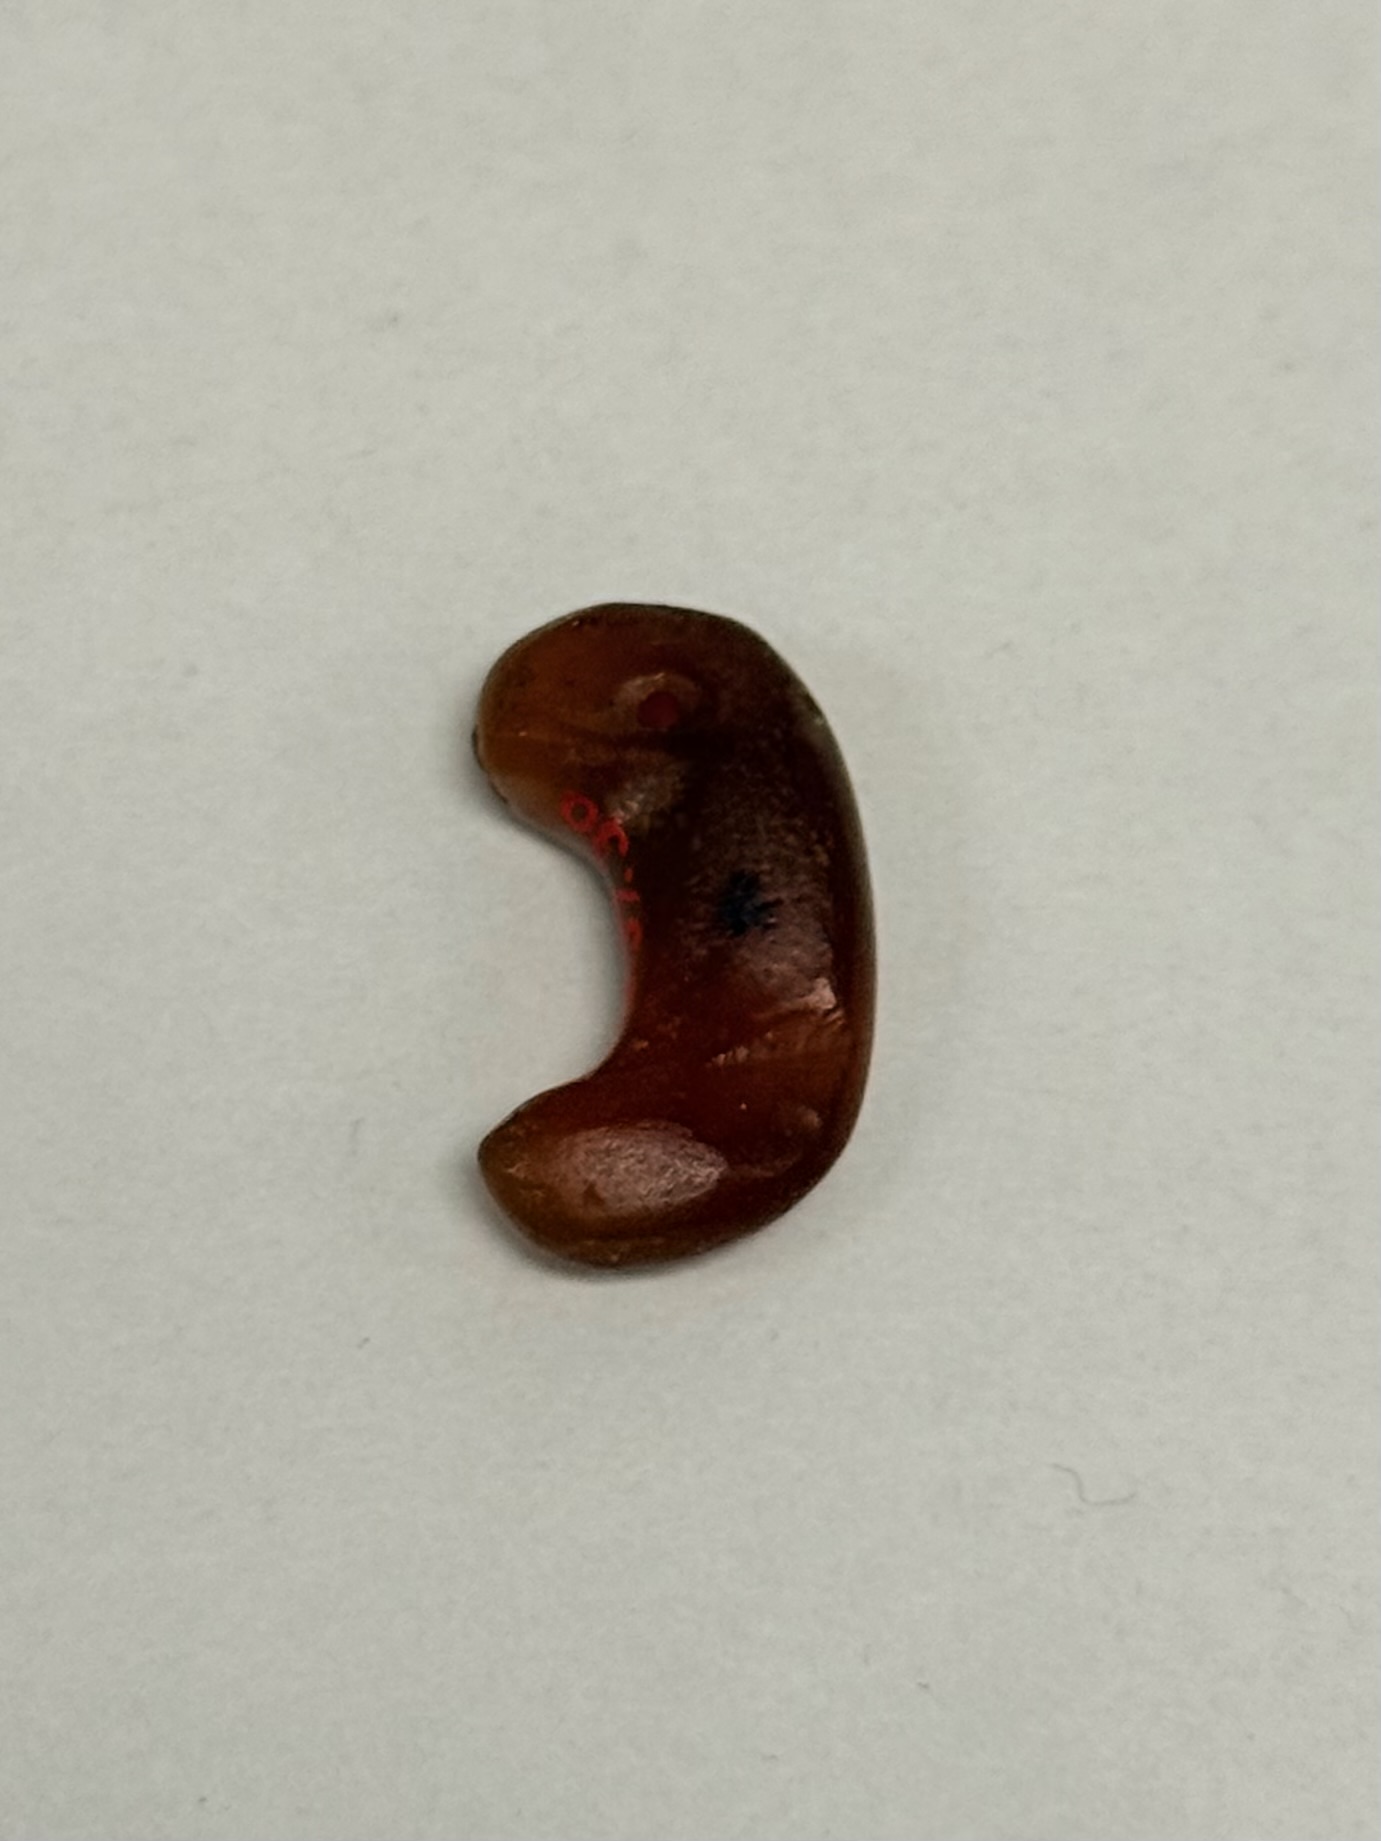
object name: jewel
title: Tiger Claw Jewel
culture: japanese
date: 601-700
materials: stone, jade, jasper